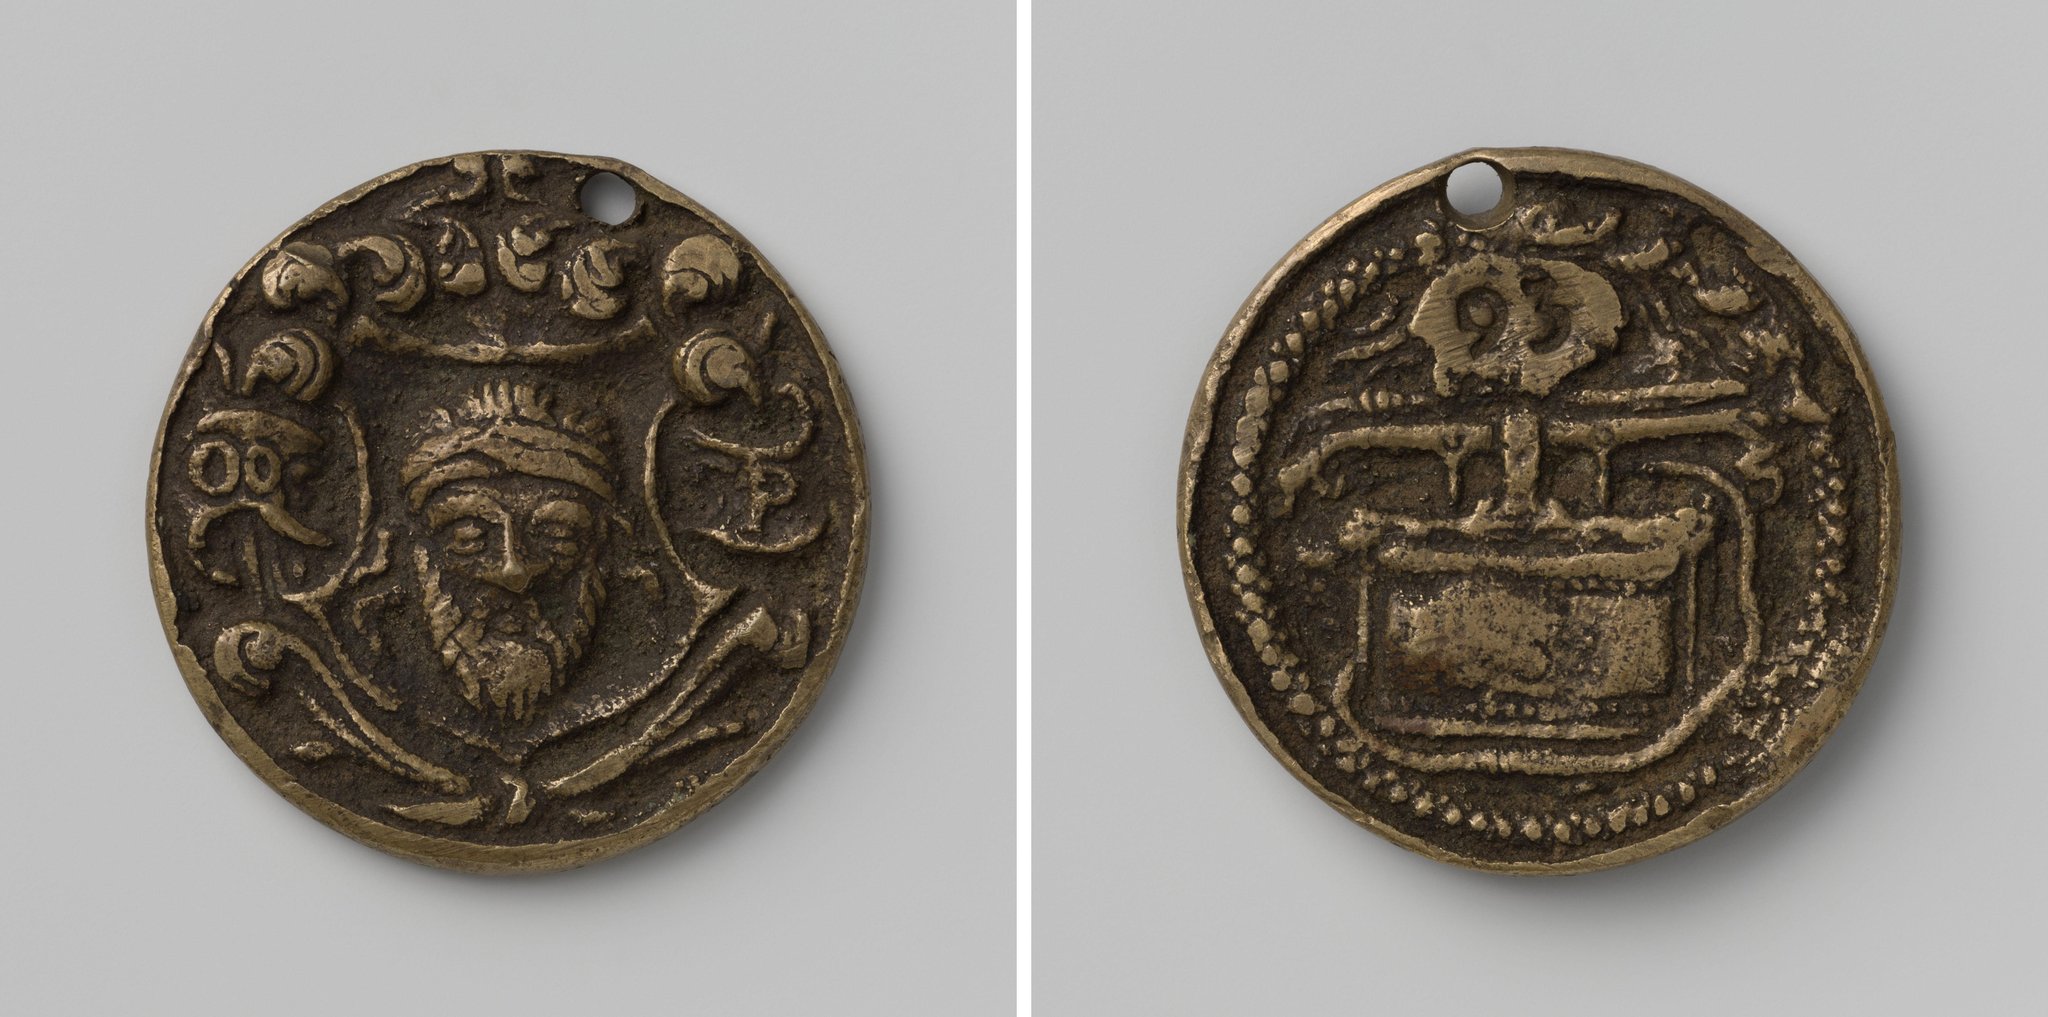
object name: medal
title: Wormer, brandspuitpenning van de Oosterspuit met no. 93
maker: Anonymous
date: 1680-1800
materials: brass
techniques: casting, engraving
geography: wormer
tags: wormer